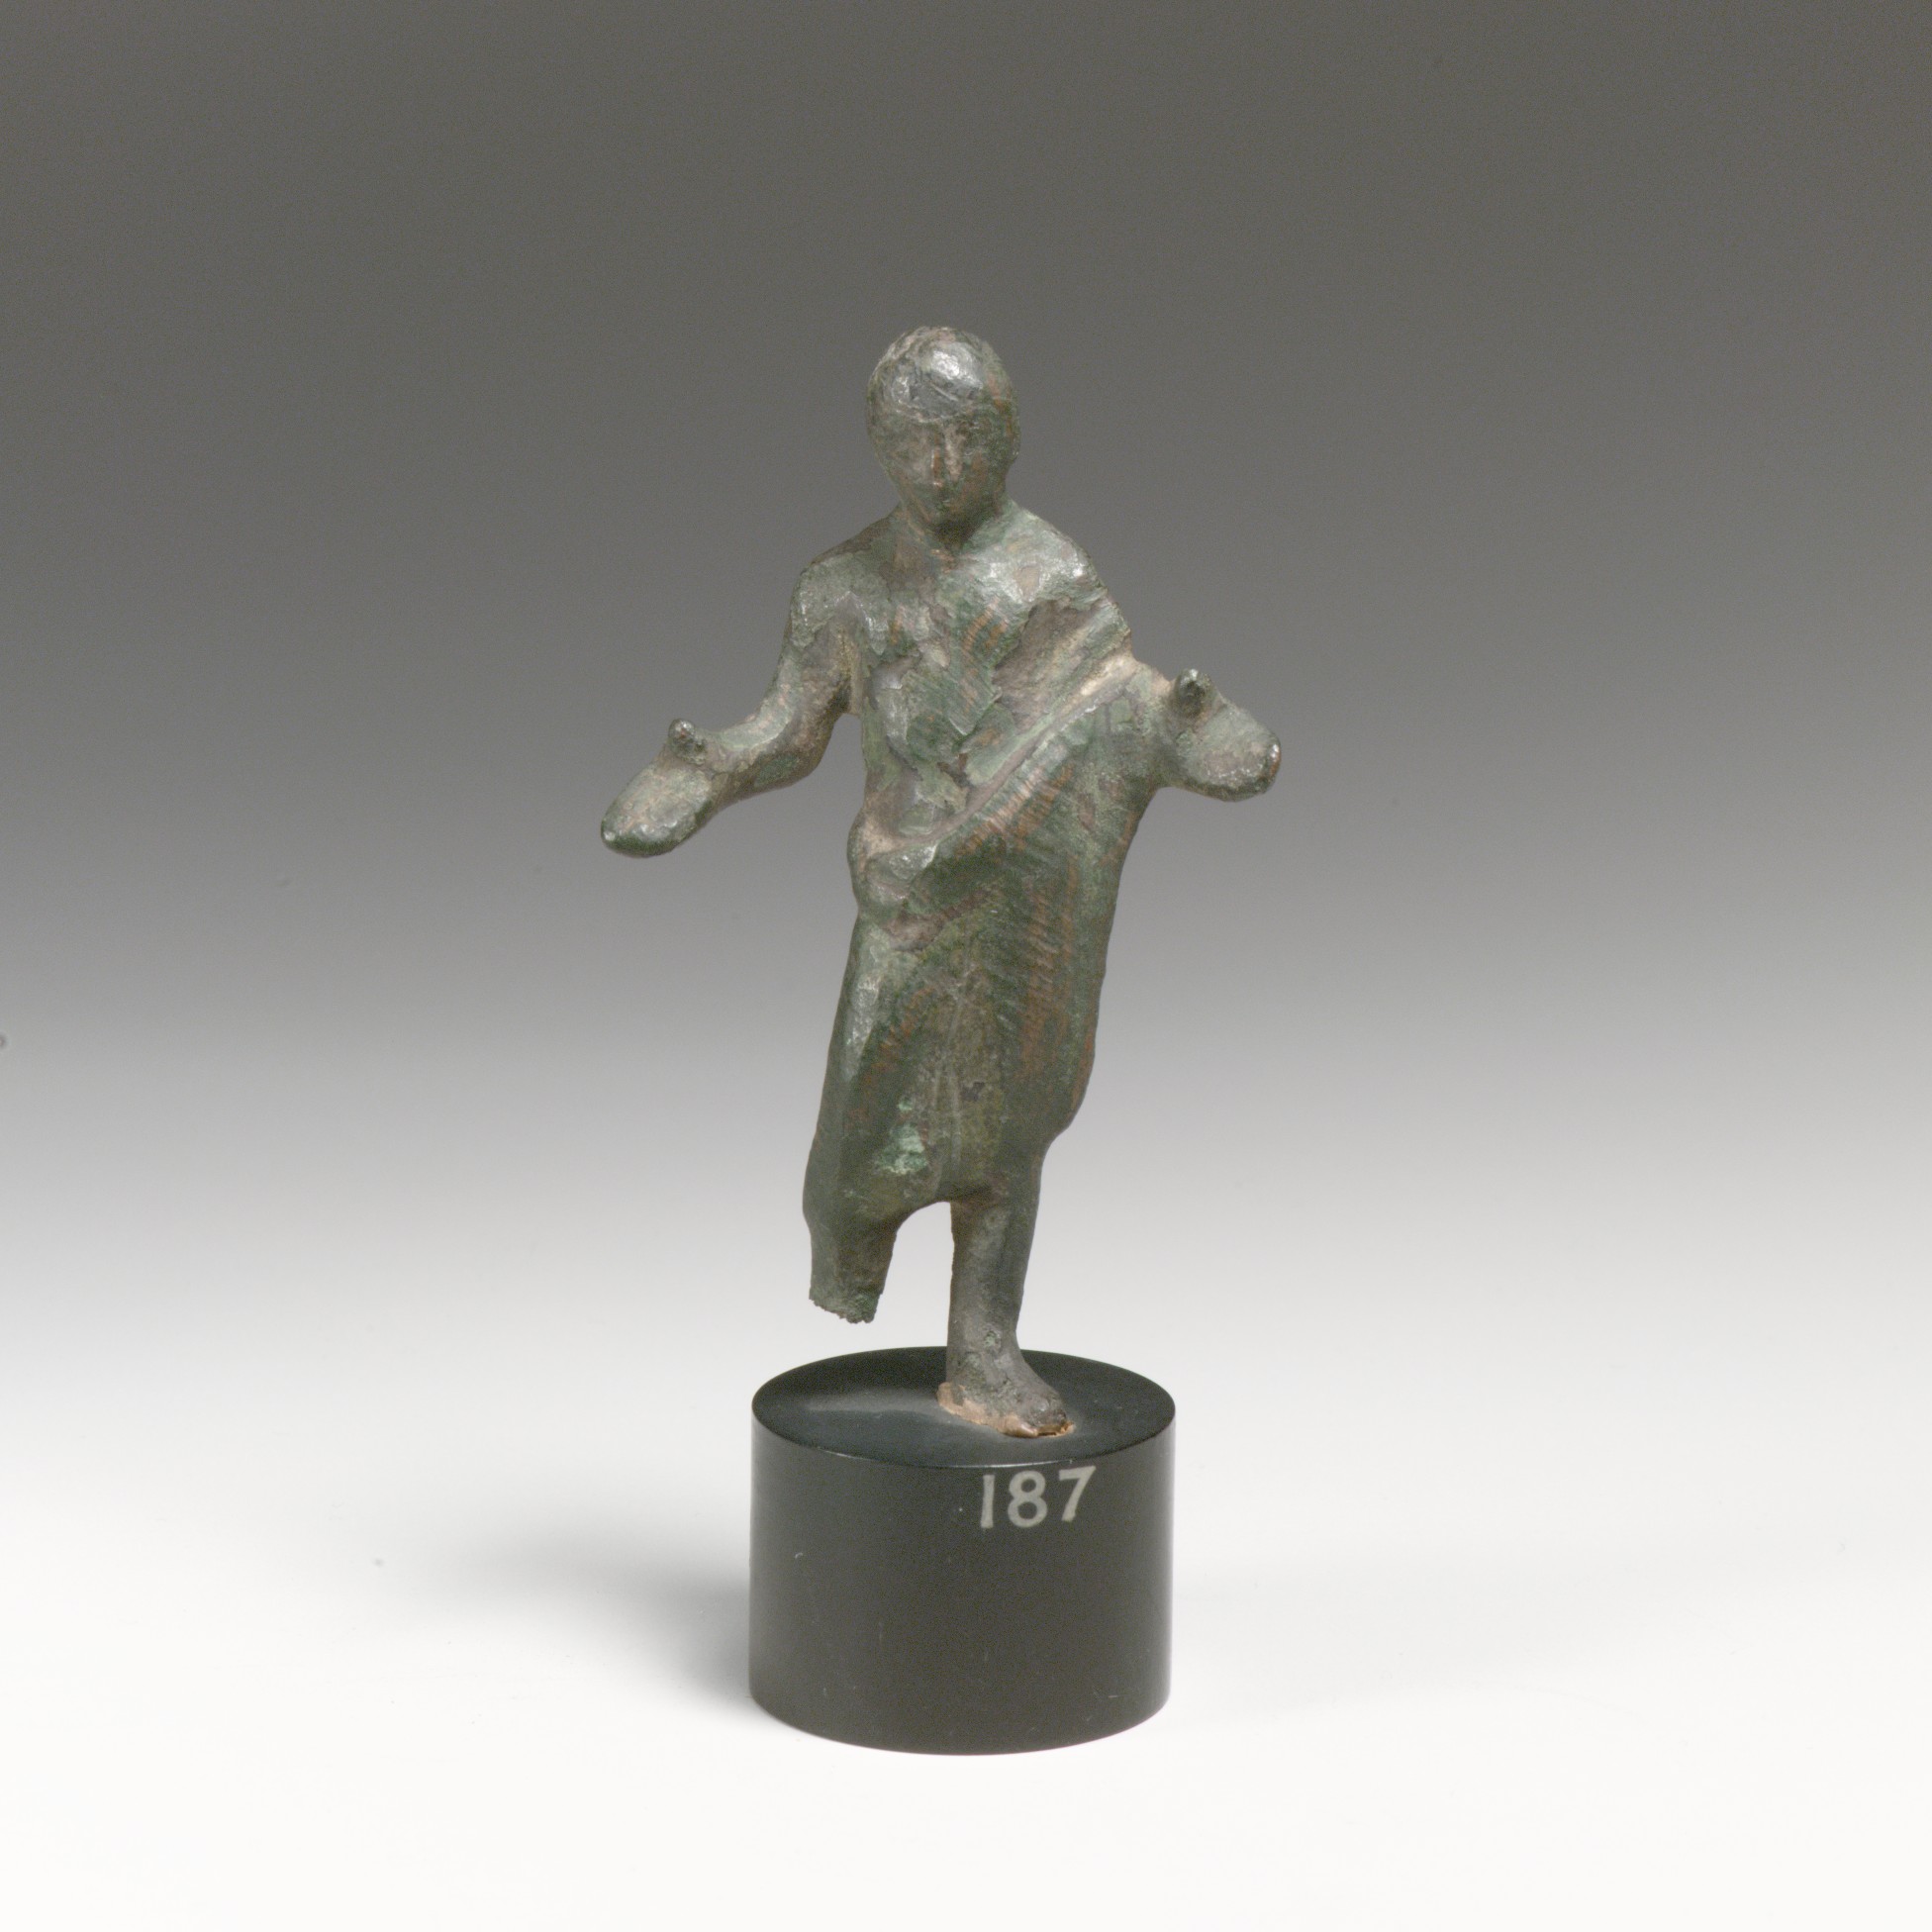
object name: statuette of an orator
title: Statuette of an orator ?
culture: italic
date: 300-1 BCE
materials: bronze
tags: men